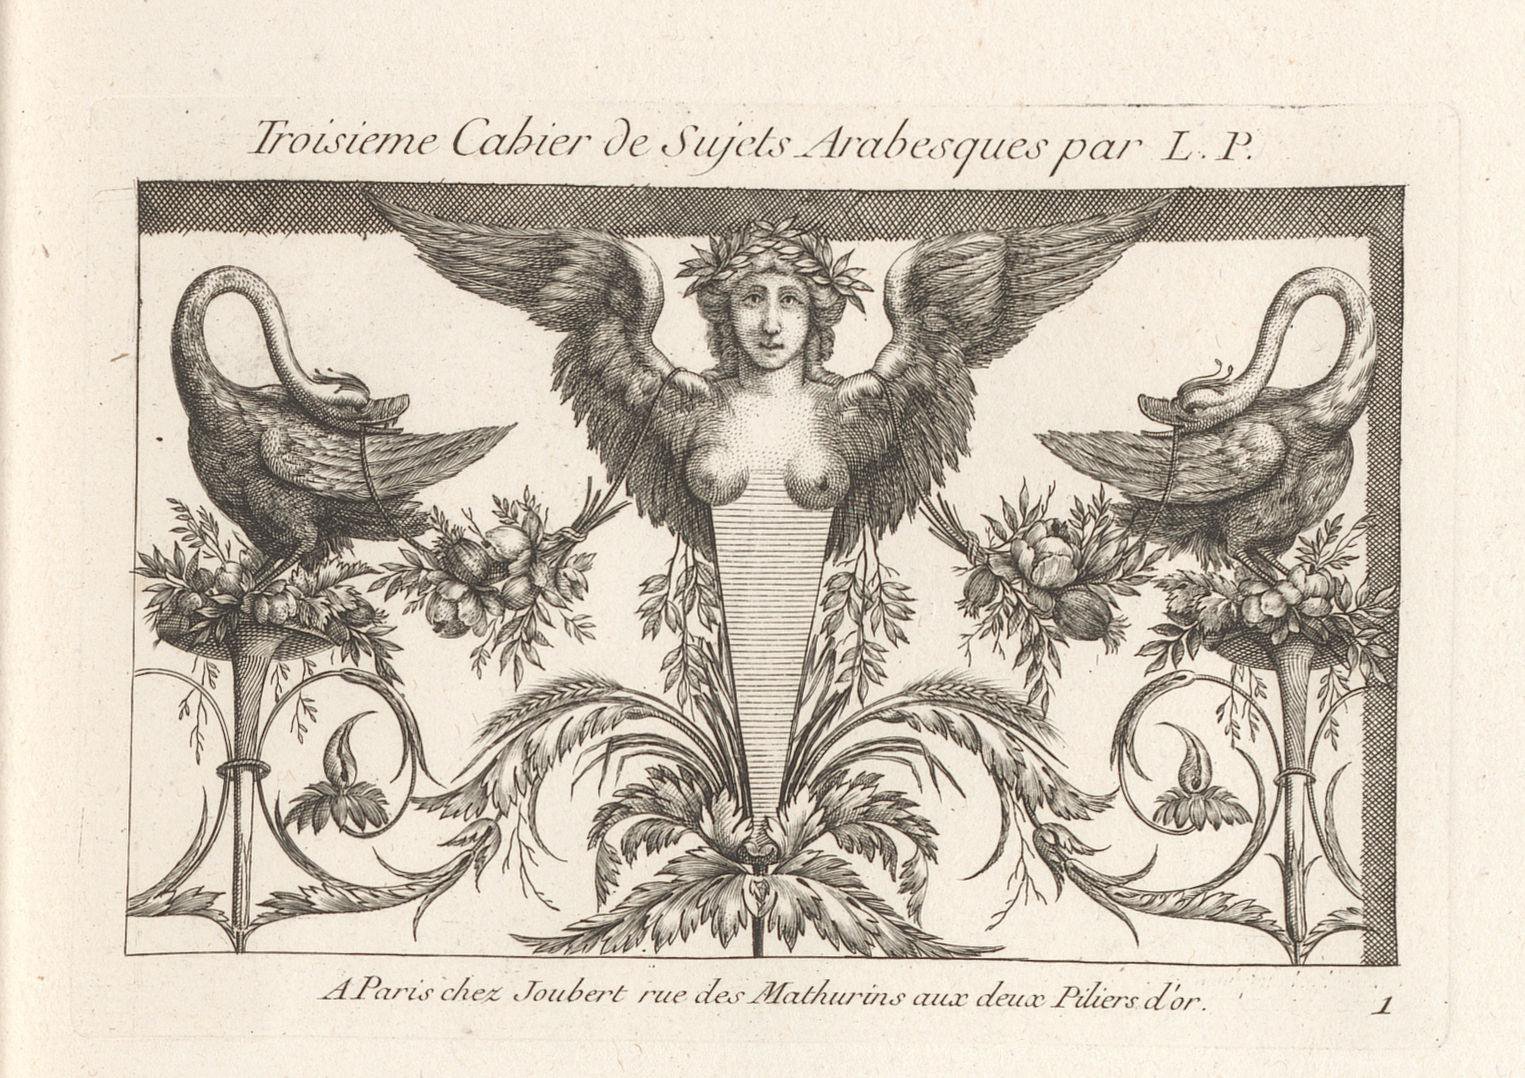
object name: titelprent, frontispice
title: Verzameling van arabesken, met de Vaticaanse loggia's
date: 1802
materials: paper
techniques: engraving, etching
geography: paris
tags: herms (garden ornaments), ornament ~ arabesque, water-birds: swan, ornament derived from plant forms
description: Doordat dit album bestaat uit meerdere, deels eerder uitgegeven prentreeksen, is de datering niet consequent. Het geheel is op de titelpagina gedateerd op 1802. Deze reeks is niet afzonderlijk gedateerd. De serietitel voor het gehele werk is "Recueil d'arabesques, contenant les loges du Vatican". De andere serietitel is de titel van de specifieke reeks binnen het geheel.